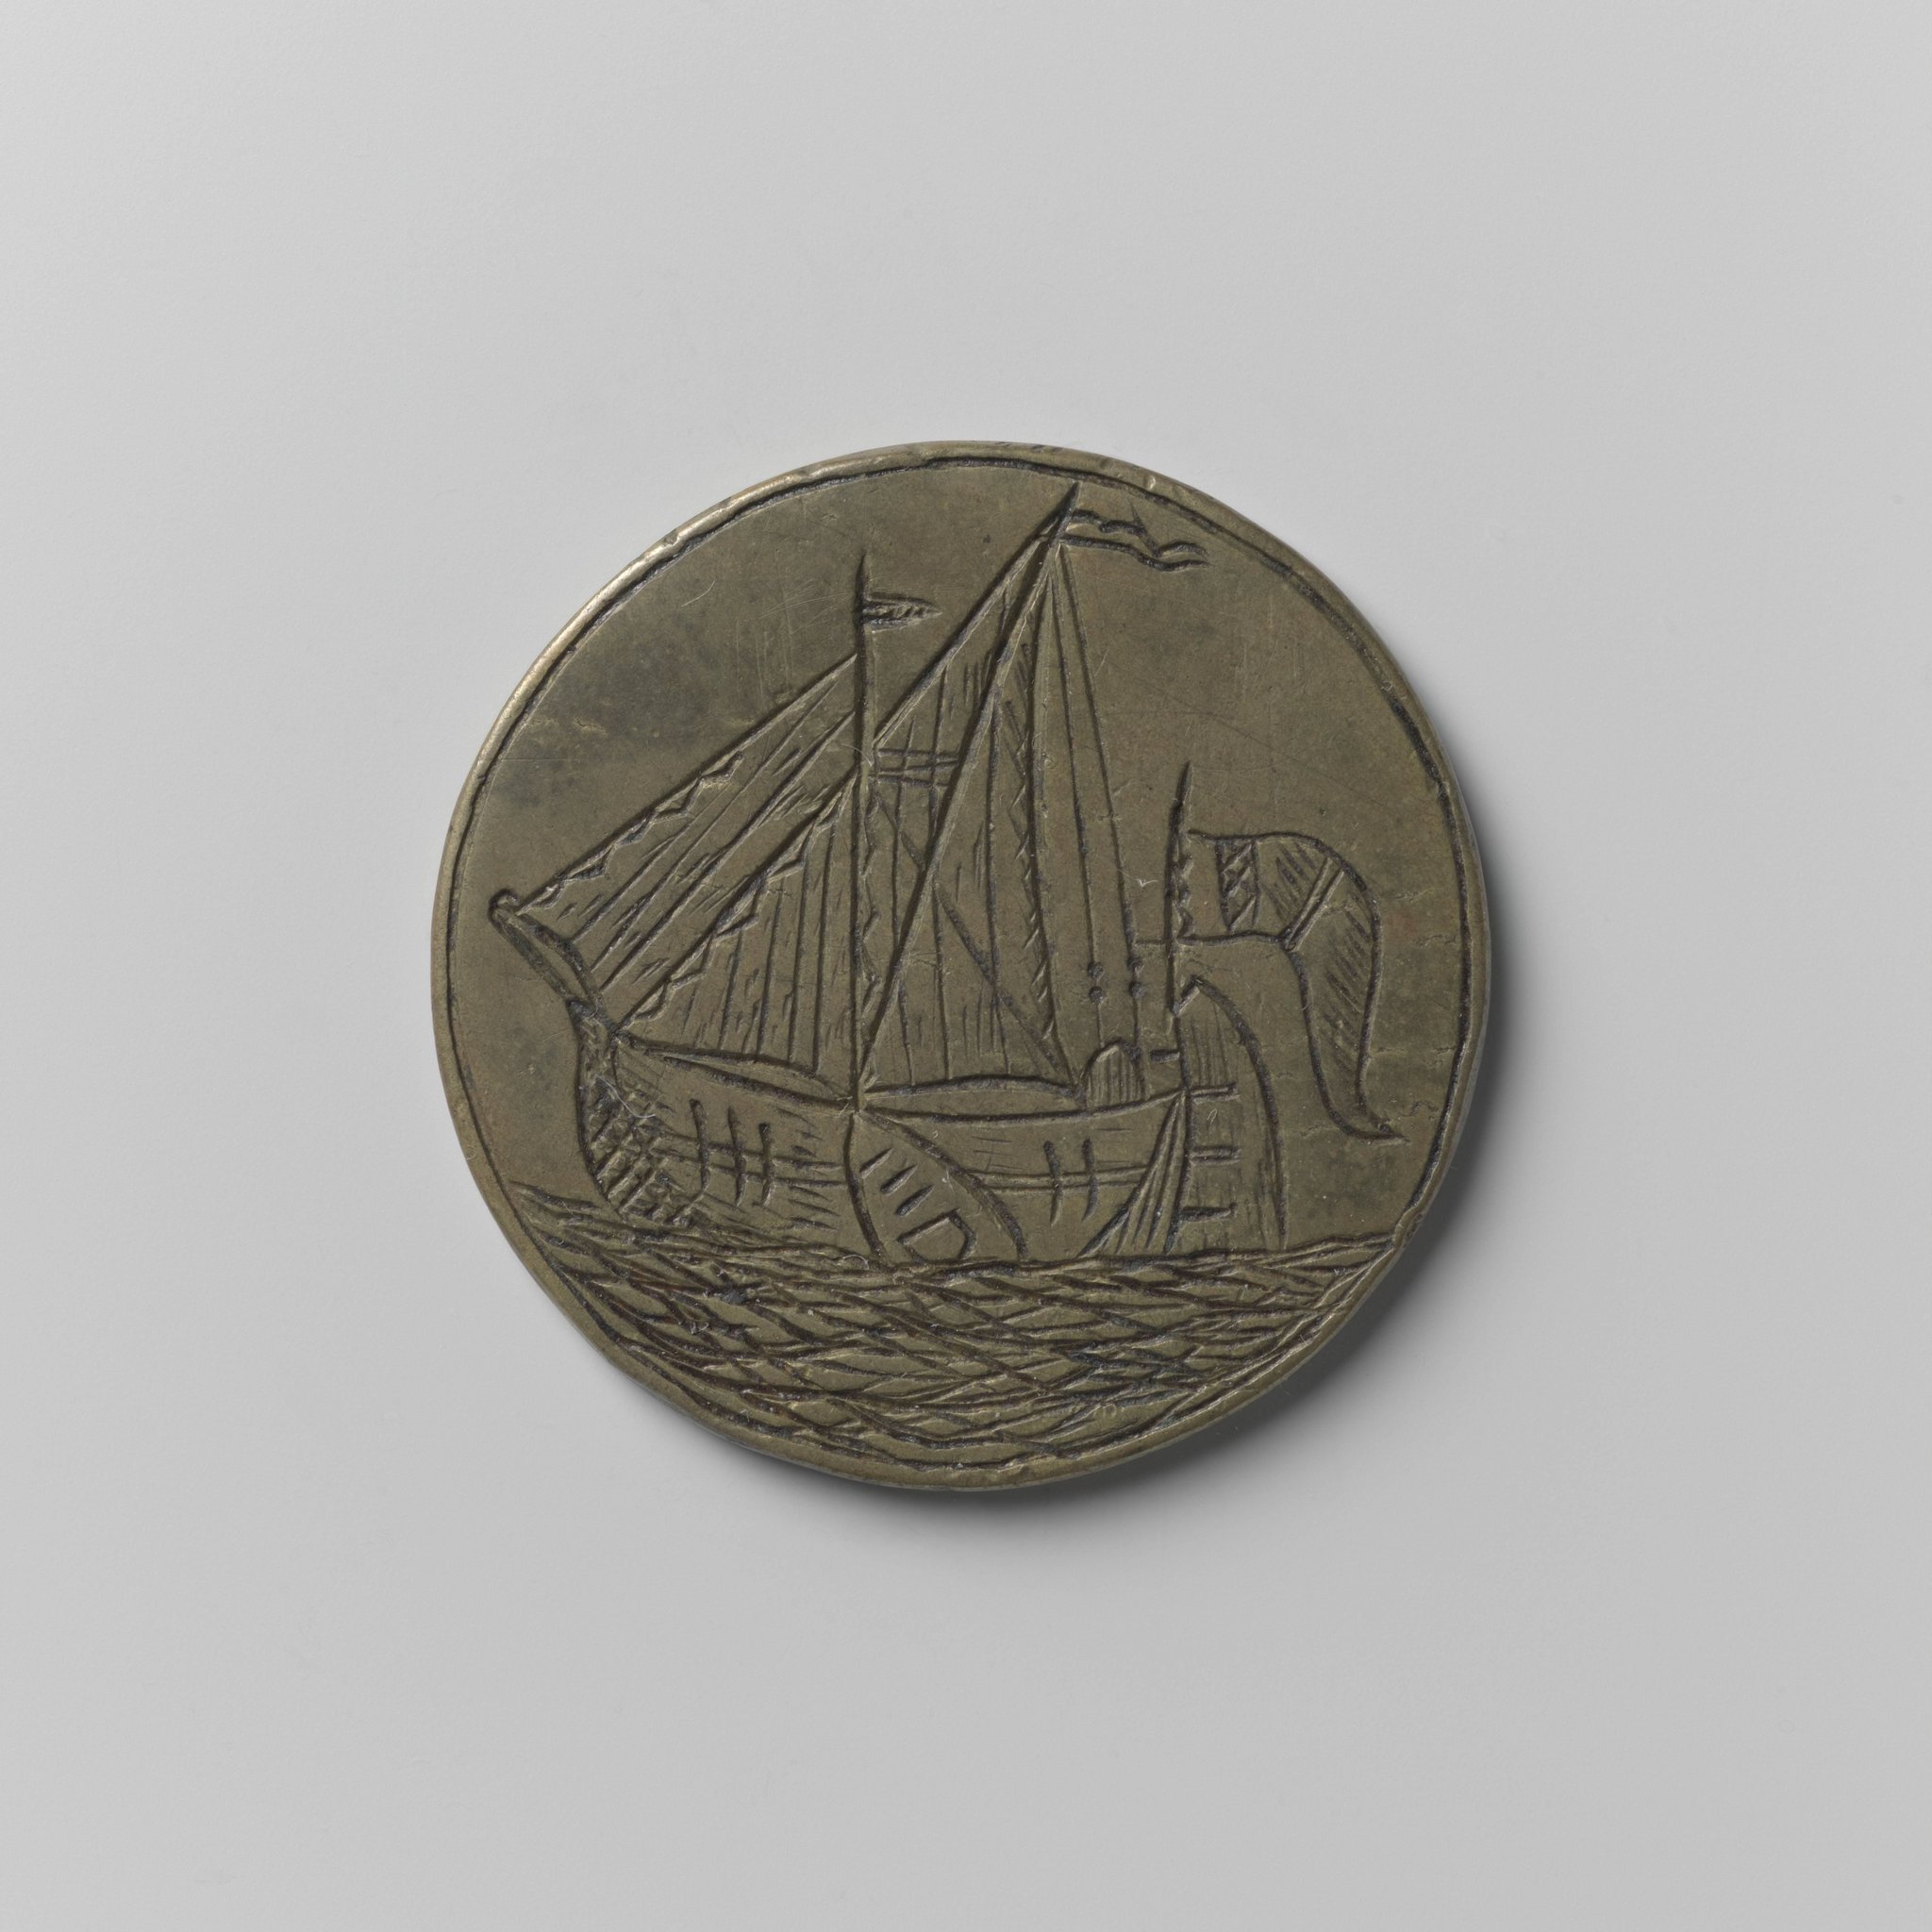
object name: medal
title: Klein binnenlandsvaardersgilde van Amsterdam, gildepenning van Claas Adriaans van Amsterdam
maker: Anonymous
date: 1771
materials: brass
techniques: engraving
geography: amsterdam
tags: amsterdam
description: Messing penning. Voorzijde: naar links varend schip; op achterplecht:vlag met wapenschild. Keerzijde: opschrift